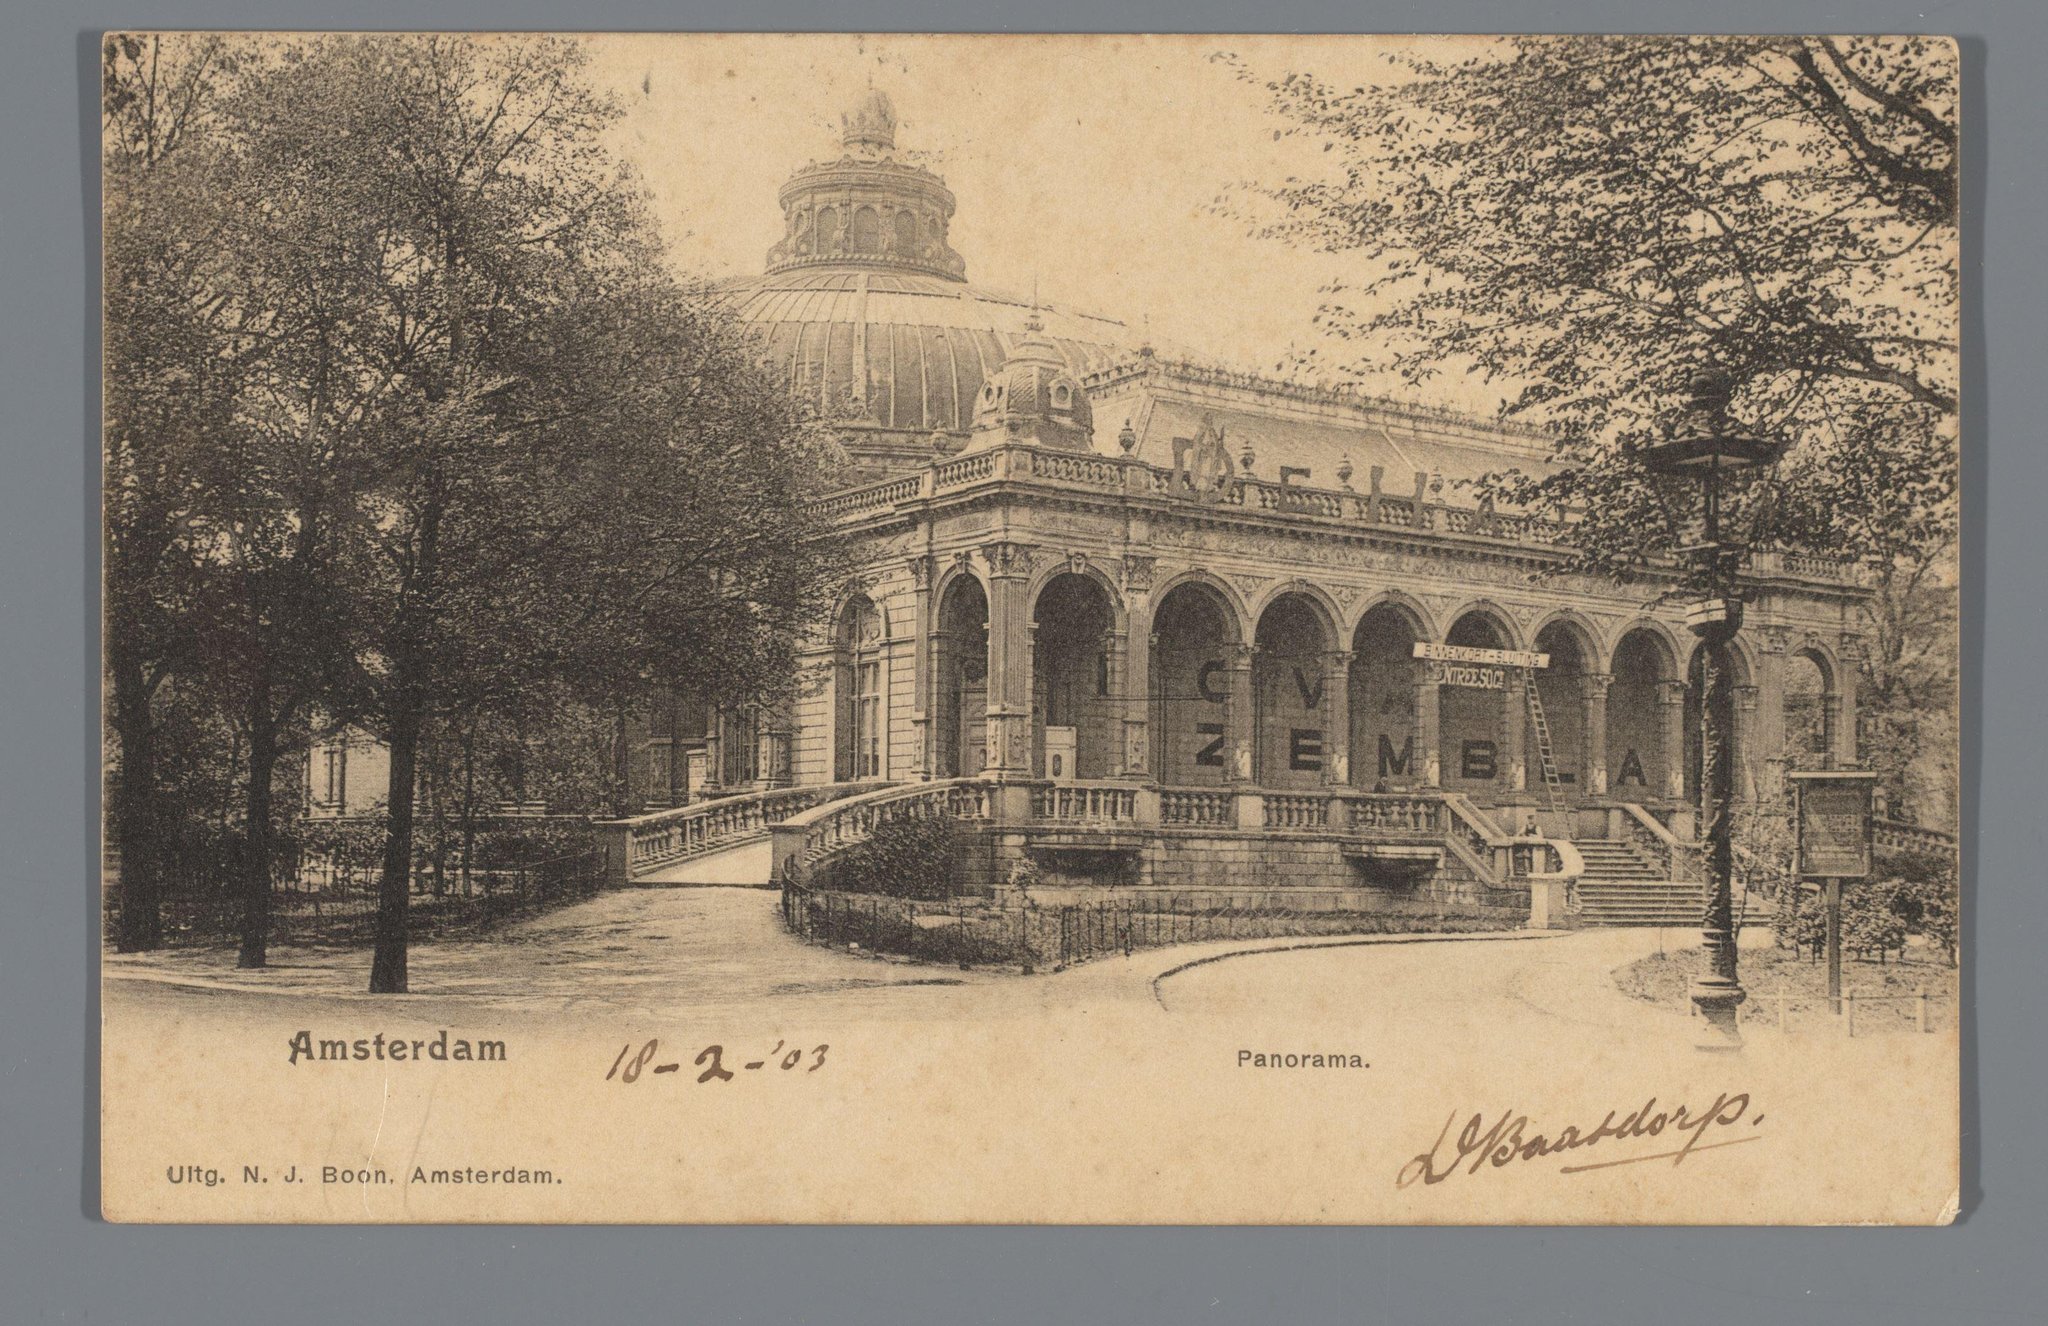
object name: ansichtkaart, prentbriefkaart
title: Het Panorama in Amsterdam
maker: nicolaas jan boon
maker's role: publisher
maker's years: 1862-1921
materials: paper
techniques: printing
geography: netherlands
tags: amsterdam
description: Briefkaart van het Panorama in Amsterdam. Op de gevel staat: 'Nova Zembla'. Gedateerd: 18-2-03.